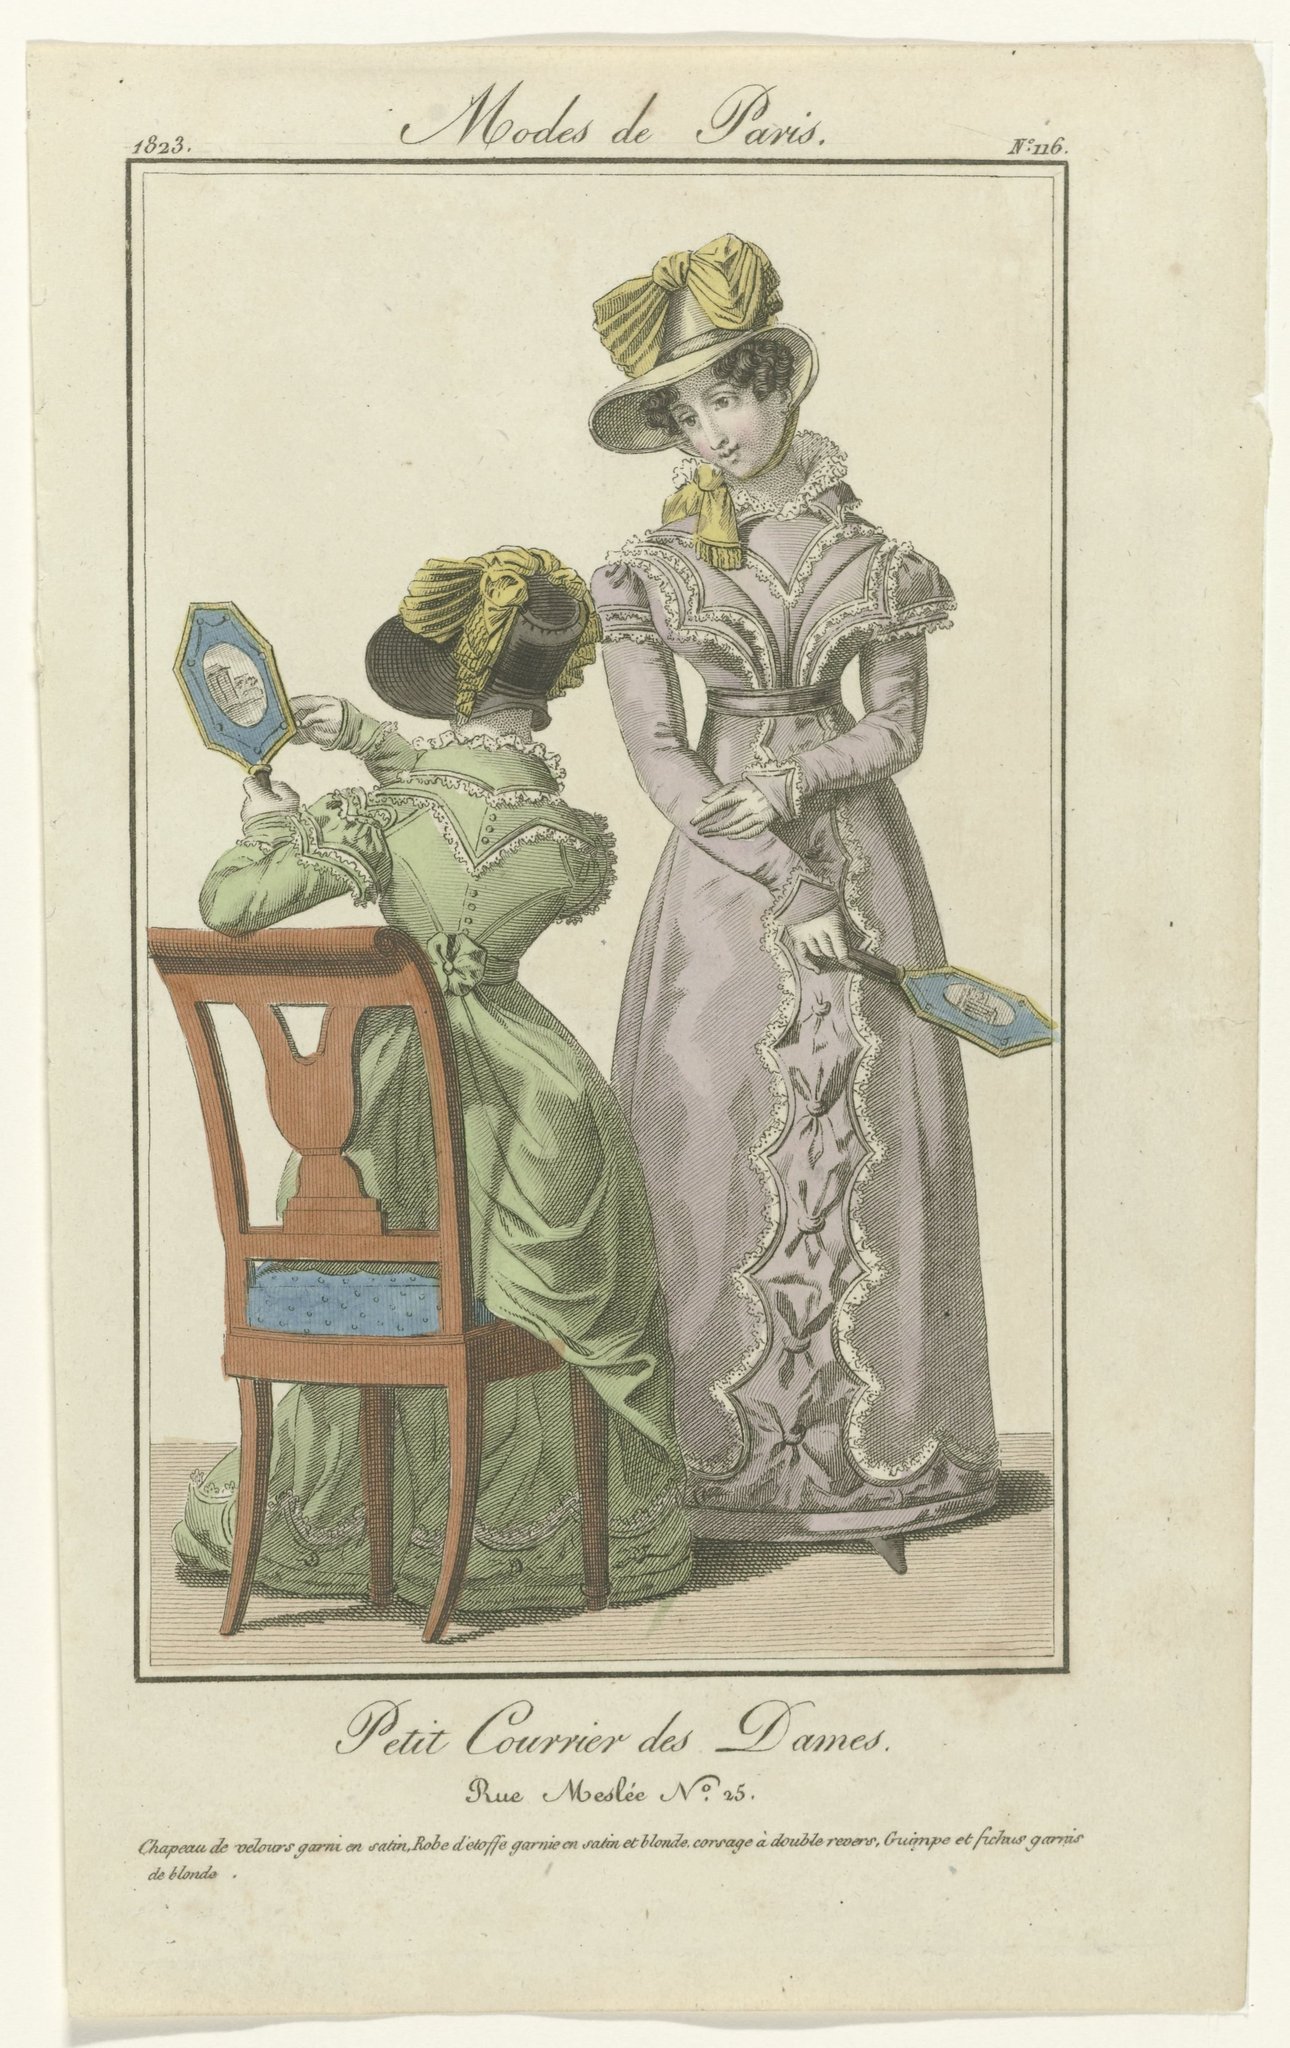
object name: fashion print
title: Petit Courrier des Dames, 1823, No. 116 : Chapeau de velours (...)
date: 1823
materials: paper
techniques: engraving, hand coloring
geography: paris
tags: neck-gear ~ clothing (revers) (+ women's clothes), lace (+ women's clothes), piece of clothing covering the breast or décolleté (guimpe) (+ women's clothes), fashion plates, head-gear: hat (+ women's clothes), dress, gown (+ women's clothes)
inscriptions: caption: ‘Chapeau de velours garni en satin, Robe d'etoffe garnie en satin et blonde, corsage à double revers, Guimpe et fichus garnis de blonde.’, address: ‘Rue Meslée No. 25.’, title: ‘Petit Courrier des Dames’, title: ‘Modes de Paris.’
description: Staande vrouw gekleed in een japon versierd met satijn en Blonde (kloskant). Lijfje met dubbele revers. Hoed van fluweel versierd met satijn. 'Guimpe en fichu' versierd met Blonde (kloskant). Vuurscherm of stokwaaier in de hand. Naast haar een zittende vrouw, op de rug gezien, gekleed in eenzelfde japon. Prent uit het modetijdschrift Petit Courrier des Dames (1821-1868).